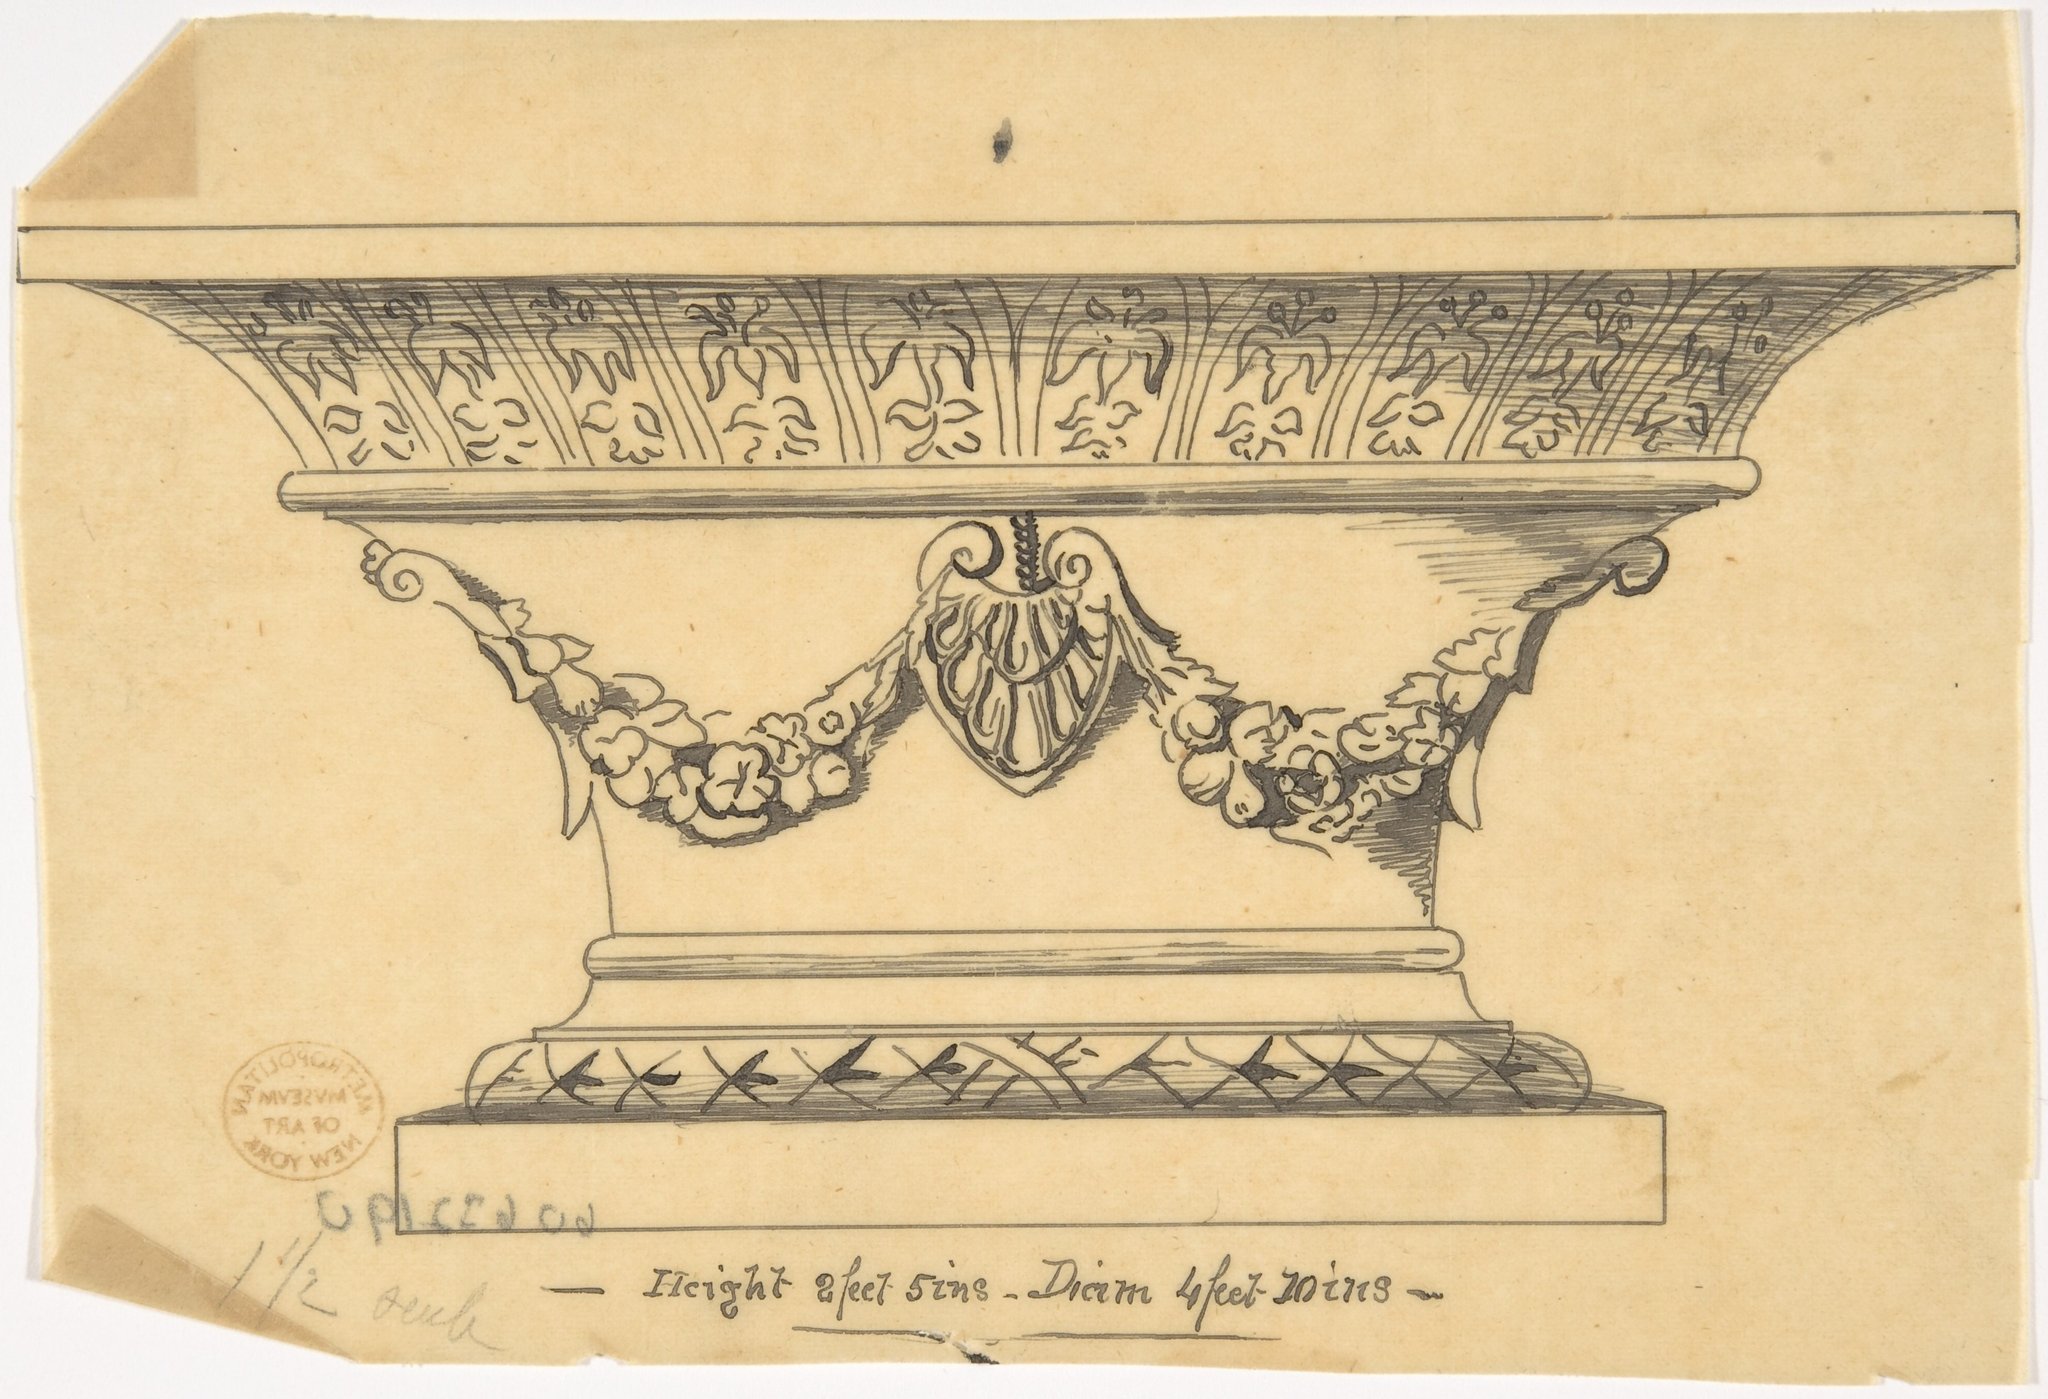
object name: drawing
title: Classical pedestal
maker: anonymous, british, 19th century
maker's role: artist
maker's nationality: british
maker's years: 1800-1900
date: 1801-1900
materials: ink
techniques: pen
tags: garlands